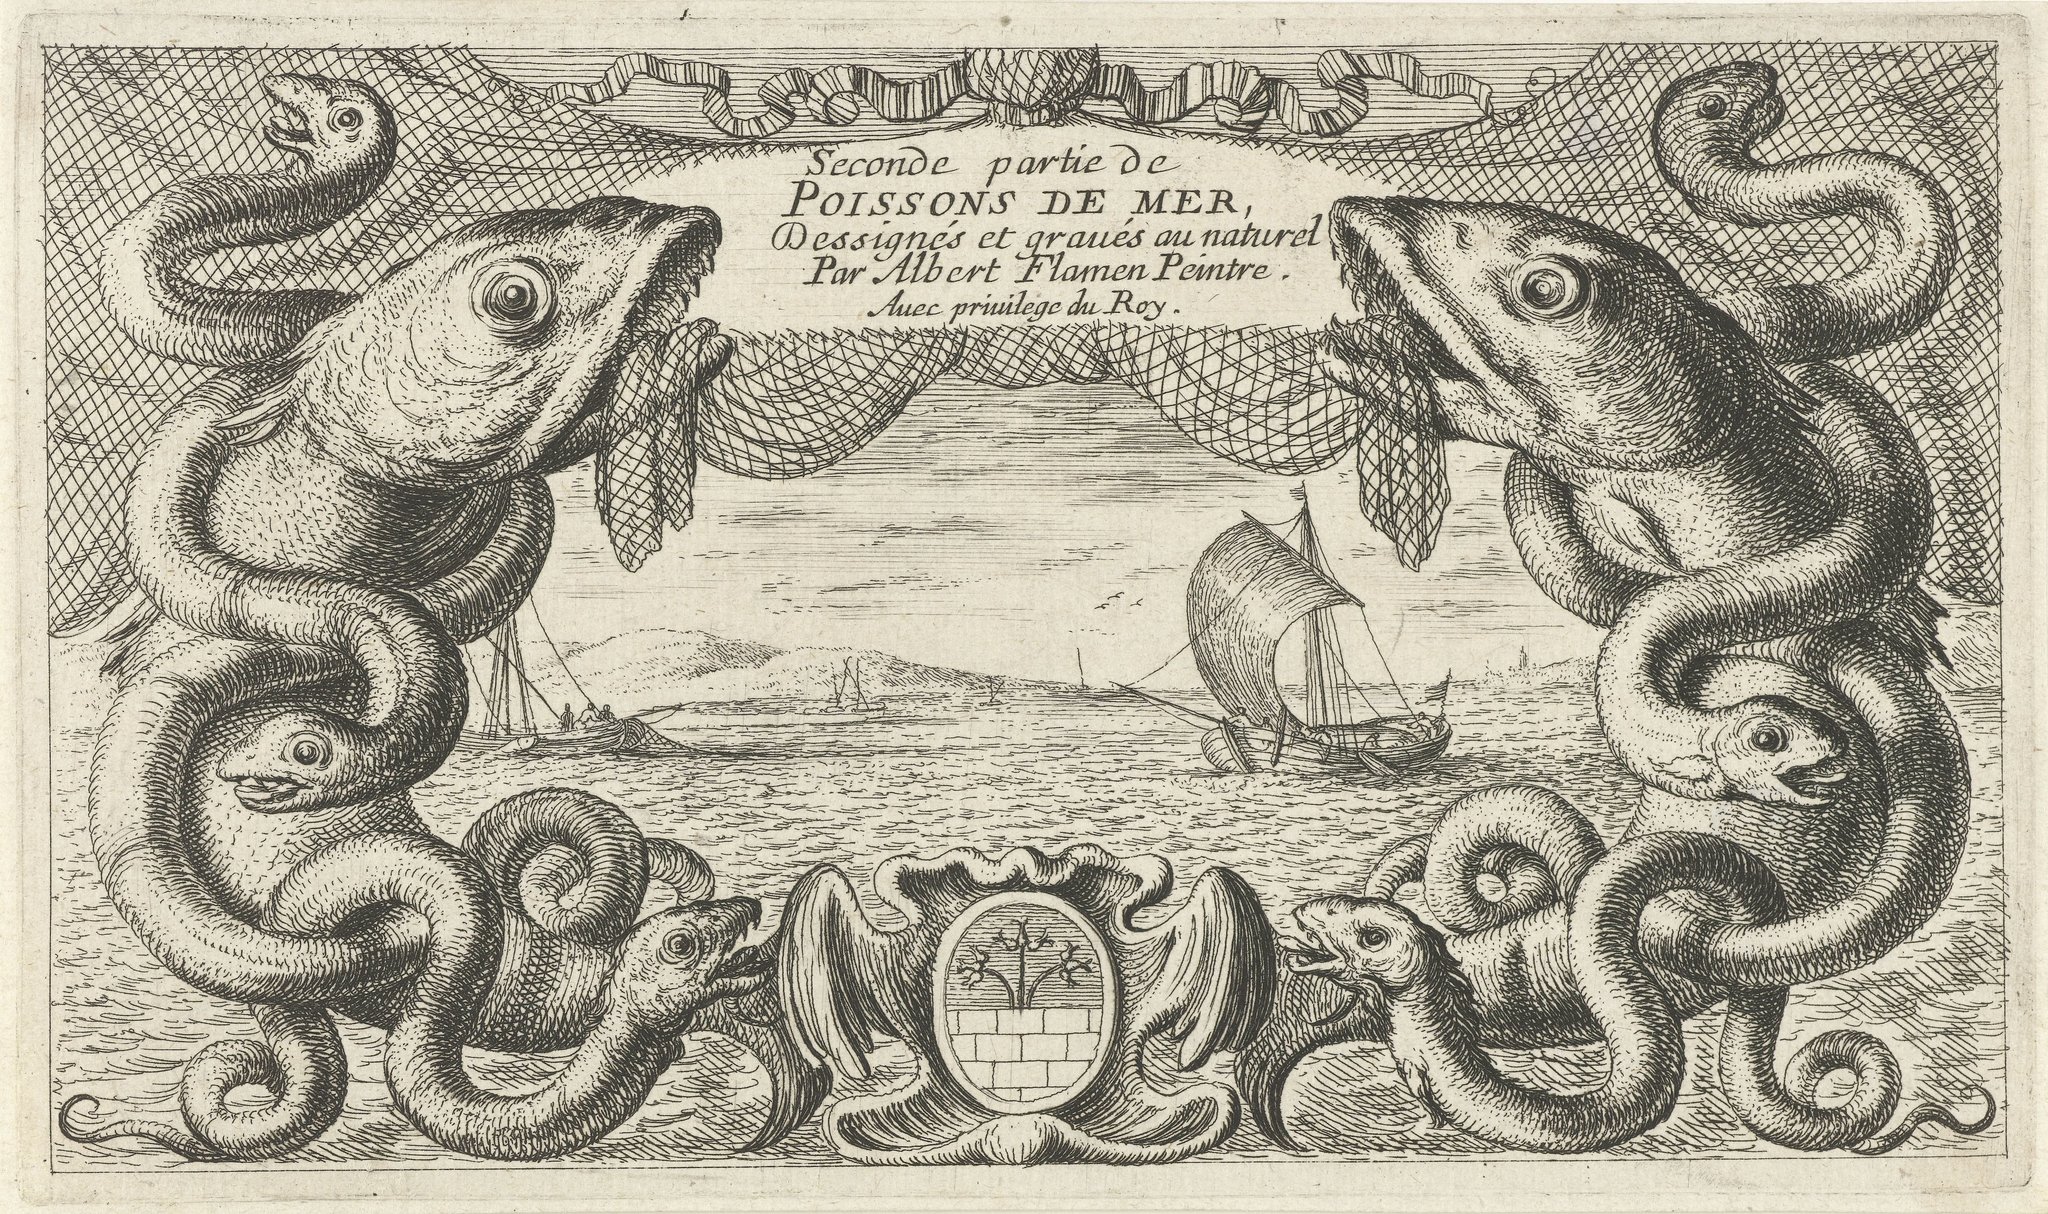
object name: print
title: Poissons de mer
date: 1664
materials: paper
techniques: etching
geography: paris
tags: fishes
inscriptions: collector's mark: Lugt 2228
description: Zeegezicht met zeilschepen, gezien door een rand van vissen, zeeslangen en een visnet. Tussen de twee vissenkoppen een cartouche met Franse tekst met serietitel en vervaardigersnamen. Onderaan het wapen van G. Tronson. Titelprent voor de tweede van vijf reeksen met verschillende vissoorten en andere zeedieren.